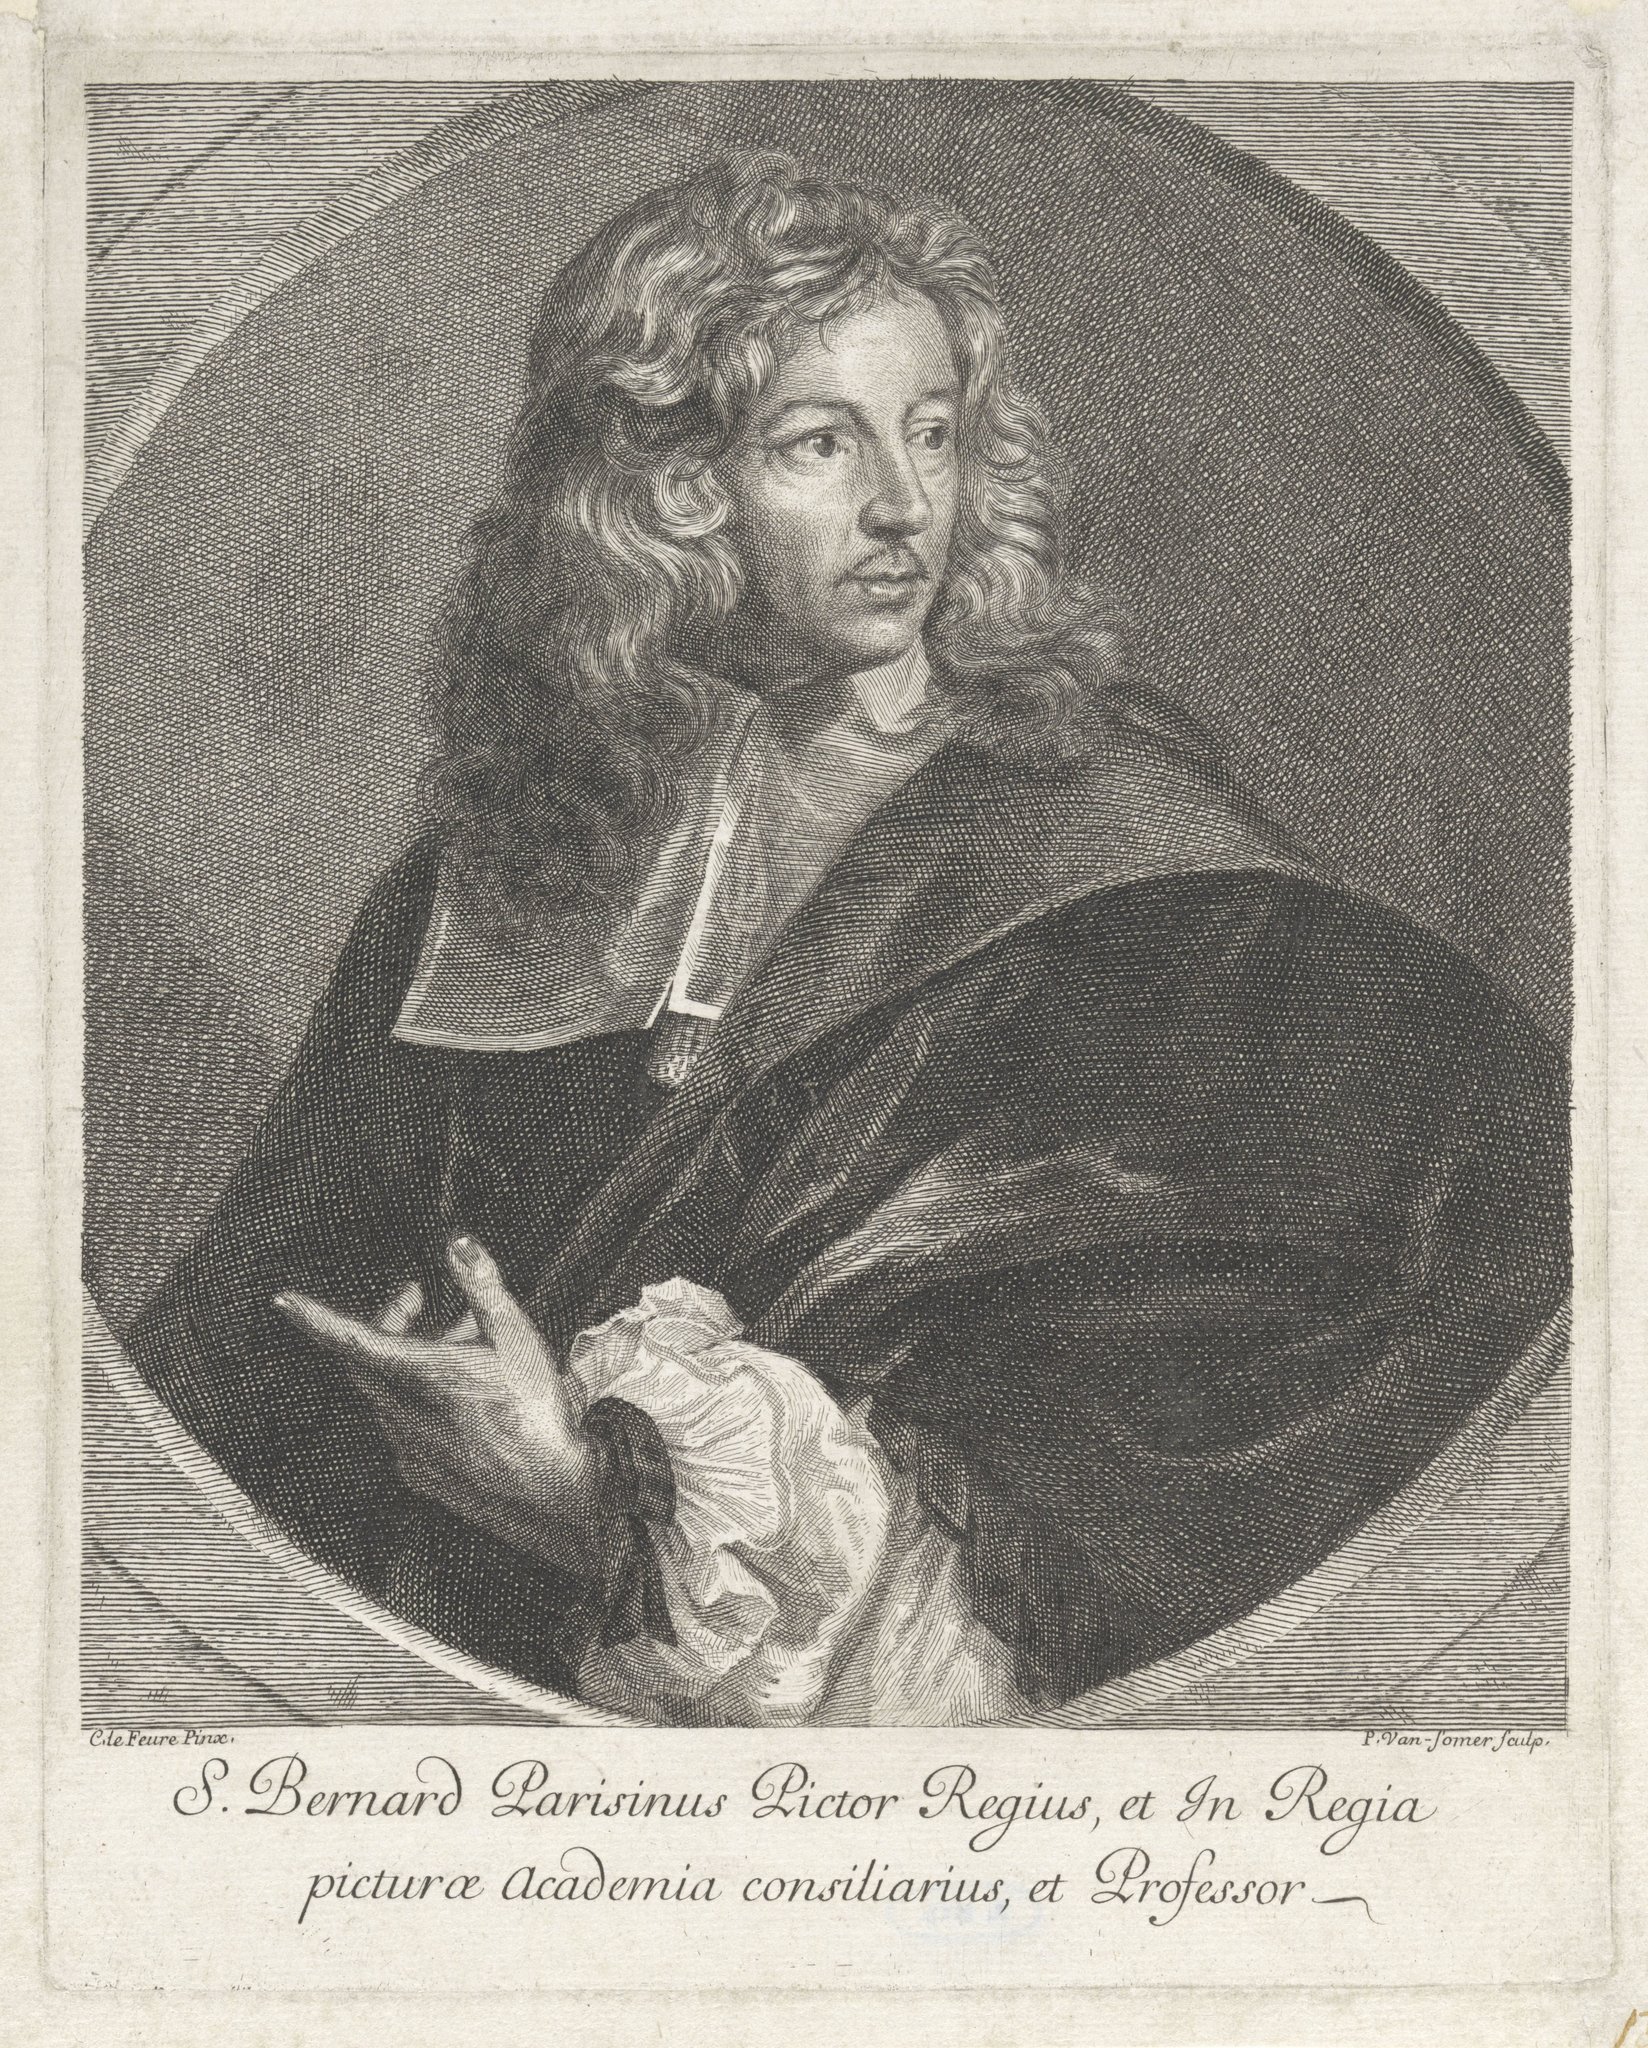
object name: print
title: Portret van Samuel-Jacques Bernard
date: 1670-1697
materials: paper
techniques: engraving, etching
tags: paris, painter, samuel-jacques bernard, portrait, self-portrait of painter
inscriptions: collector's mark: Lugt 2228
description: Portret van de Franse schilder en graveur Samuel-Jacques Bernard. Onder het portret zijn naam en functies.